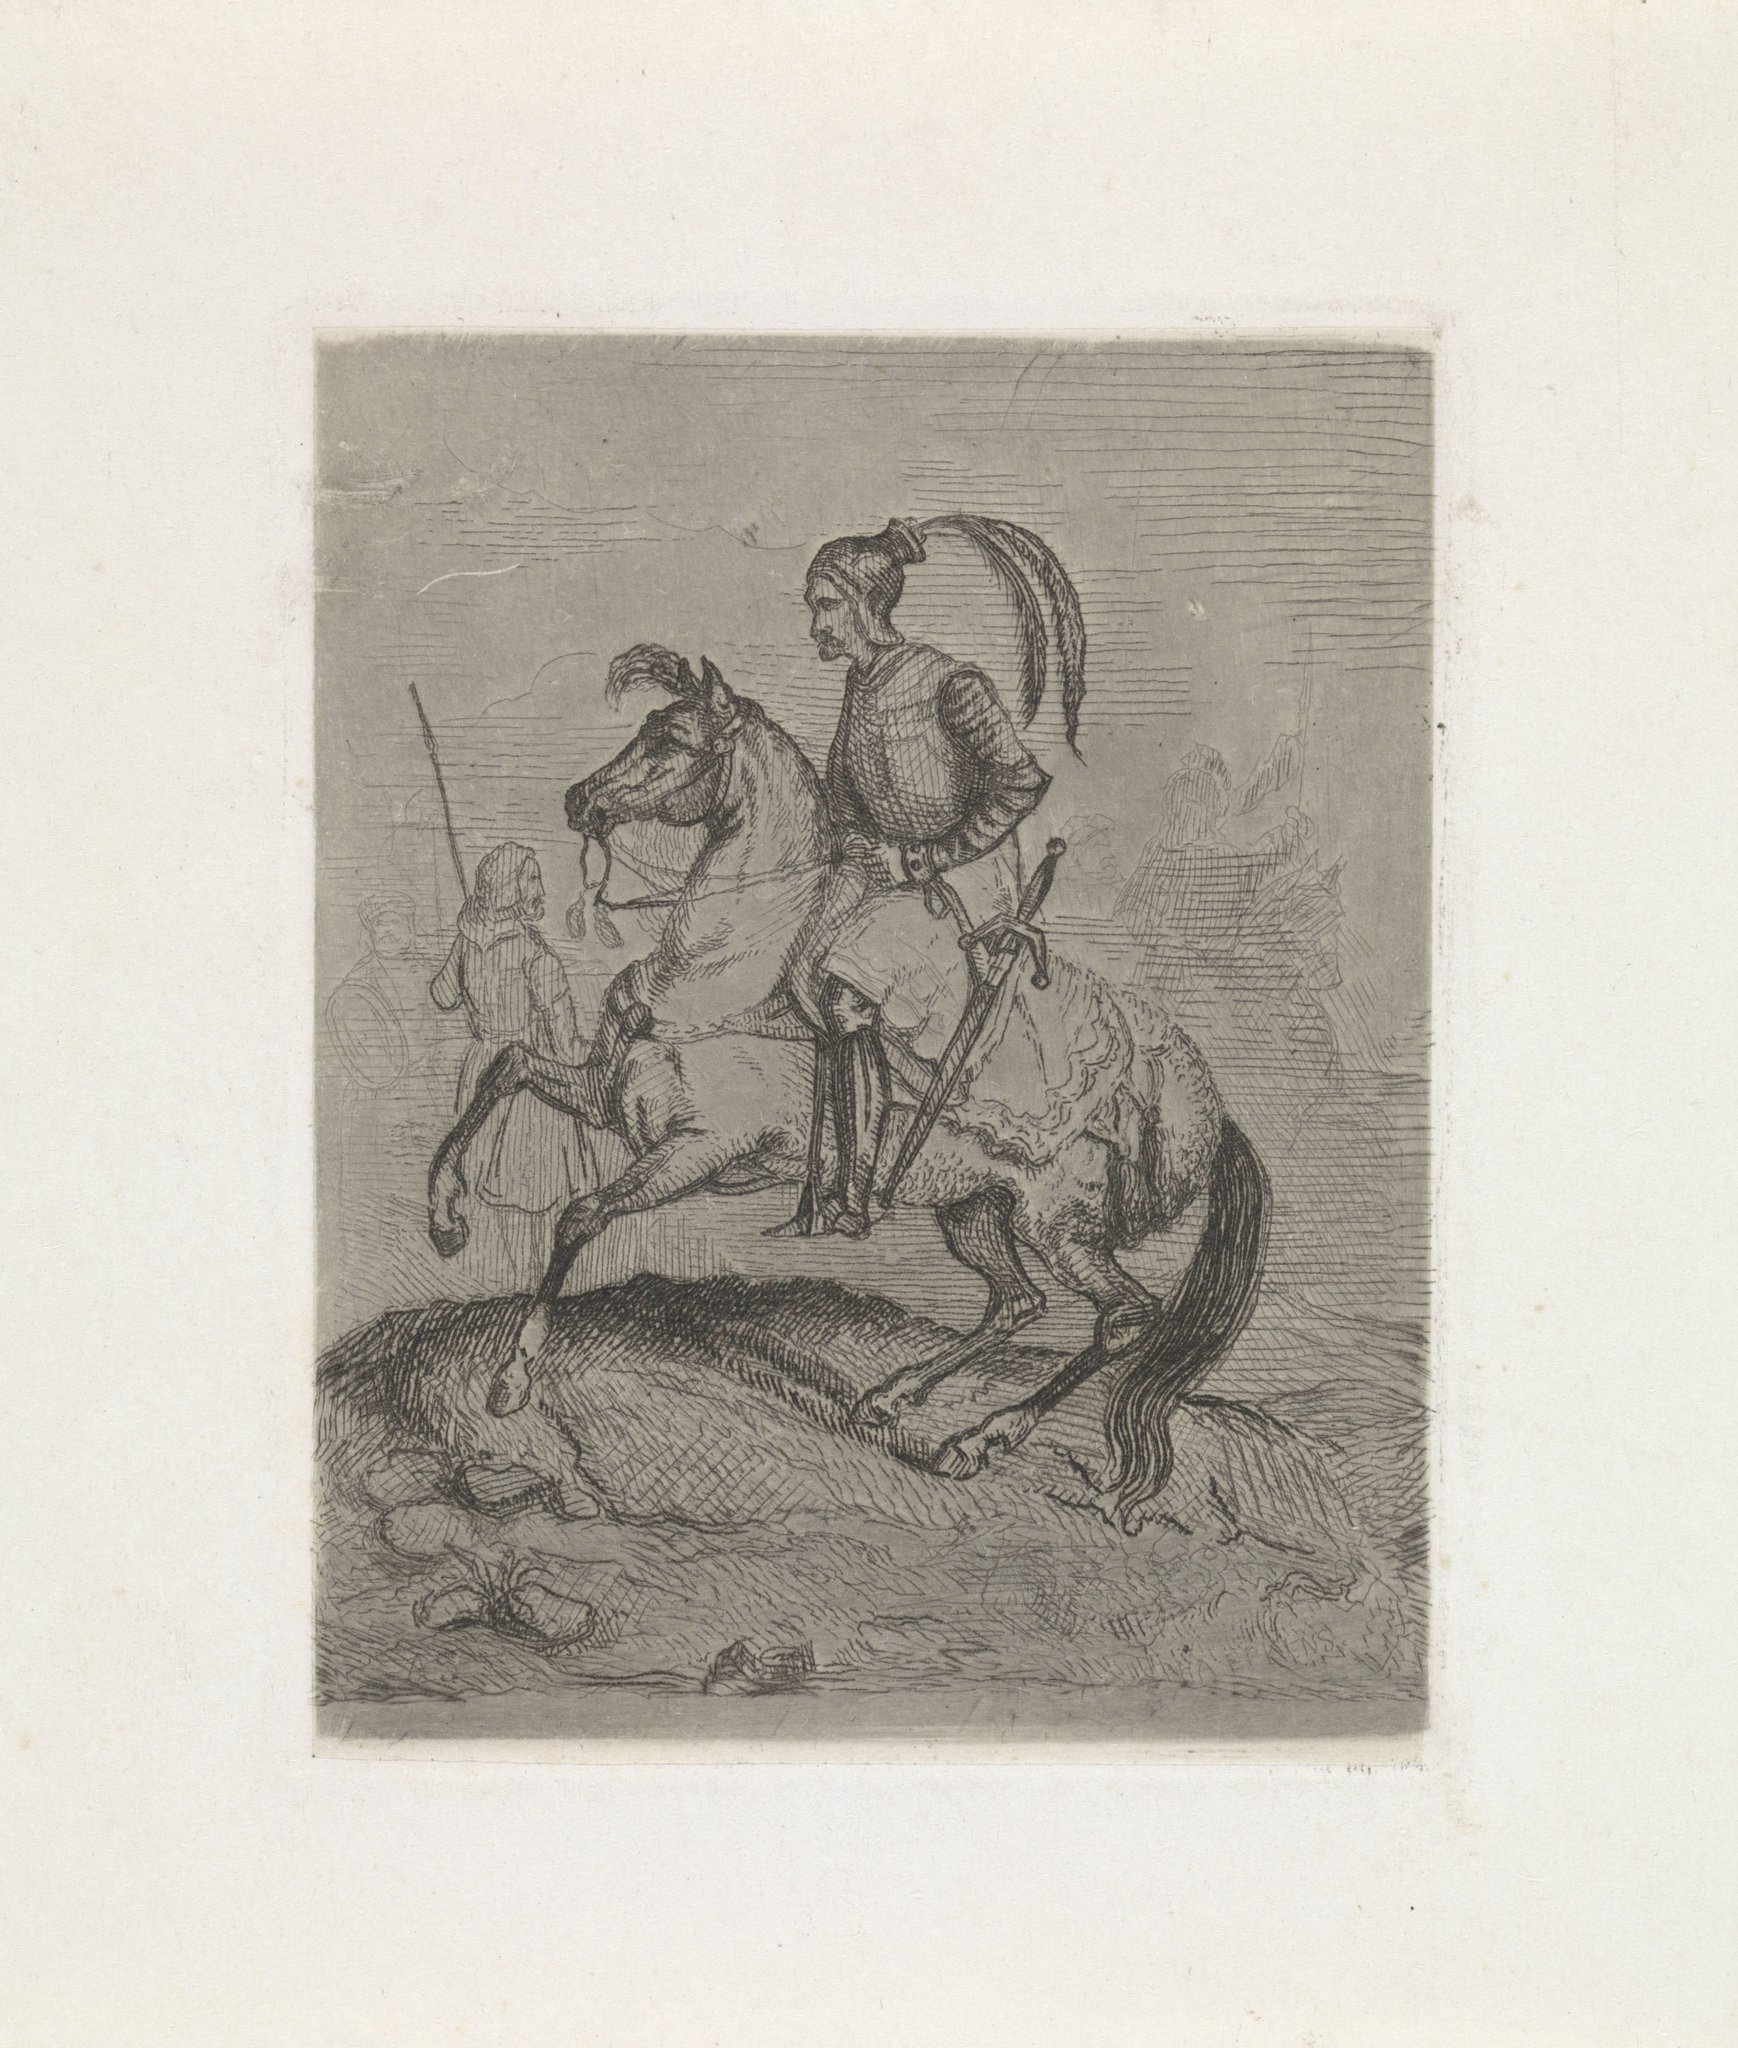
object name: print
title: Ruiter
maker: arnoud schaepkens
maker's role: print maker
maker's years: 1816-1904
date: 1855-1904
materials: paper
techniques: drypoint, etching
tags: riding a horse, ass, or mule; rider, horseman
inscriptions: collector's mark: Lugt 1485, collector's mark: Lugt 2228